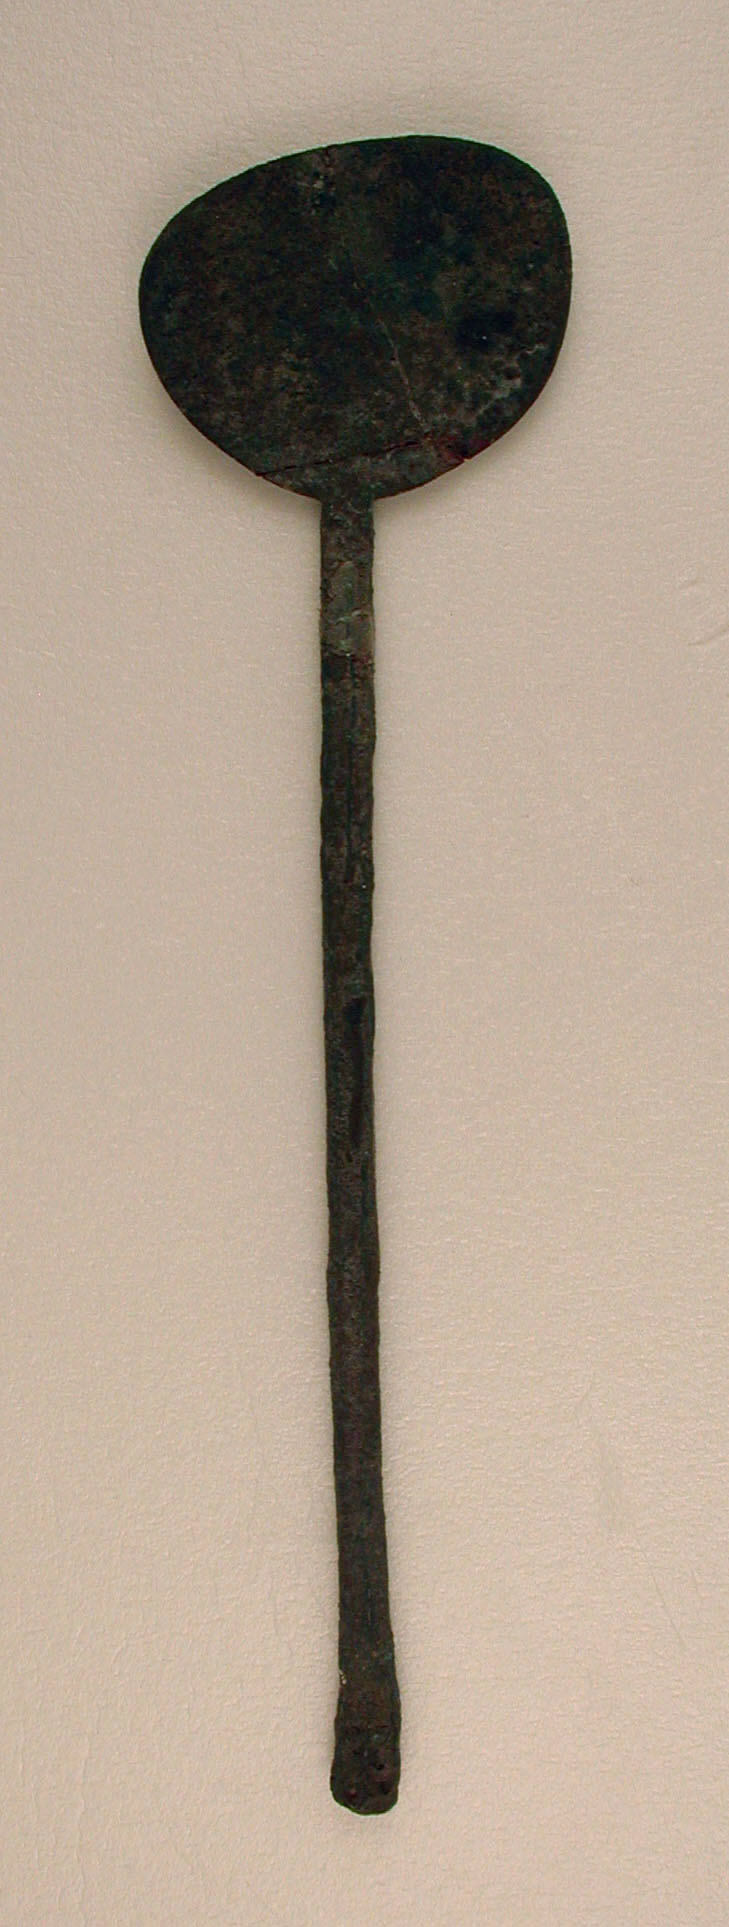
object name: spoon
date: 901-1000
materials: bronze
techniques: casting, incising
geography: iran